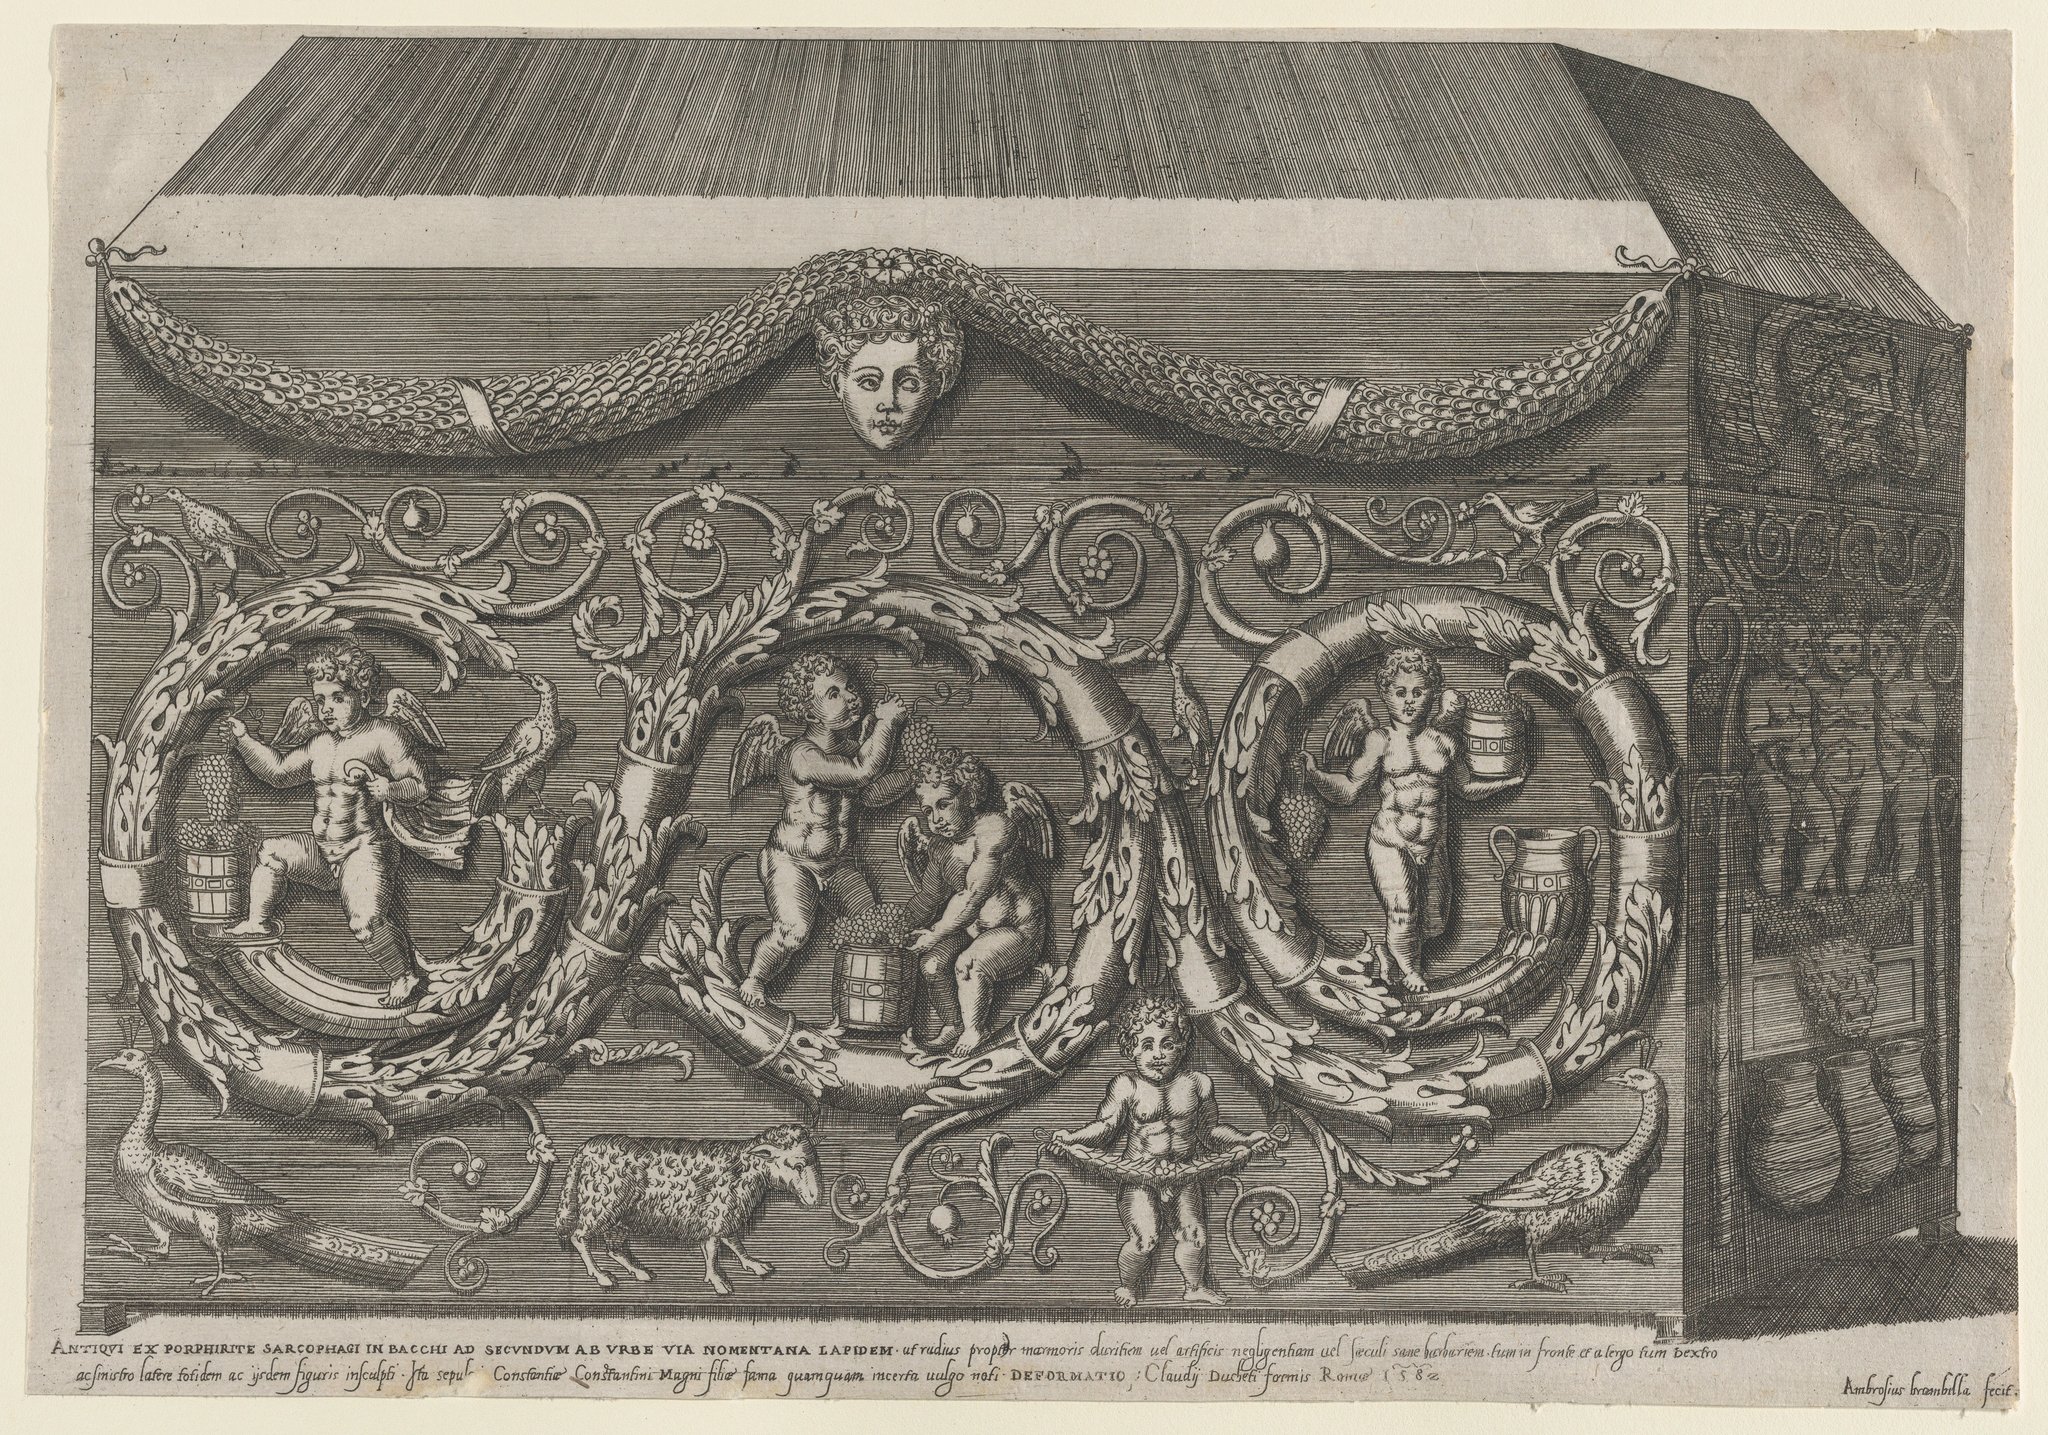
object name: print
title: Decorated Sarcophagus with Arabesques, from "Speculum Romanae Magnificentiae"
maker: giovanni ambrogio brambilla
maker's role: artist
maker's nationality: italian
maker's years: 1575-1599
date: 1582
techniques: engraving, etching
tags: ornament,peacocks,sheep,sarcophagus